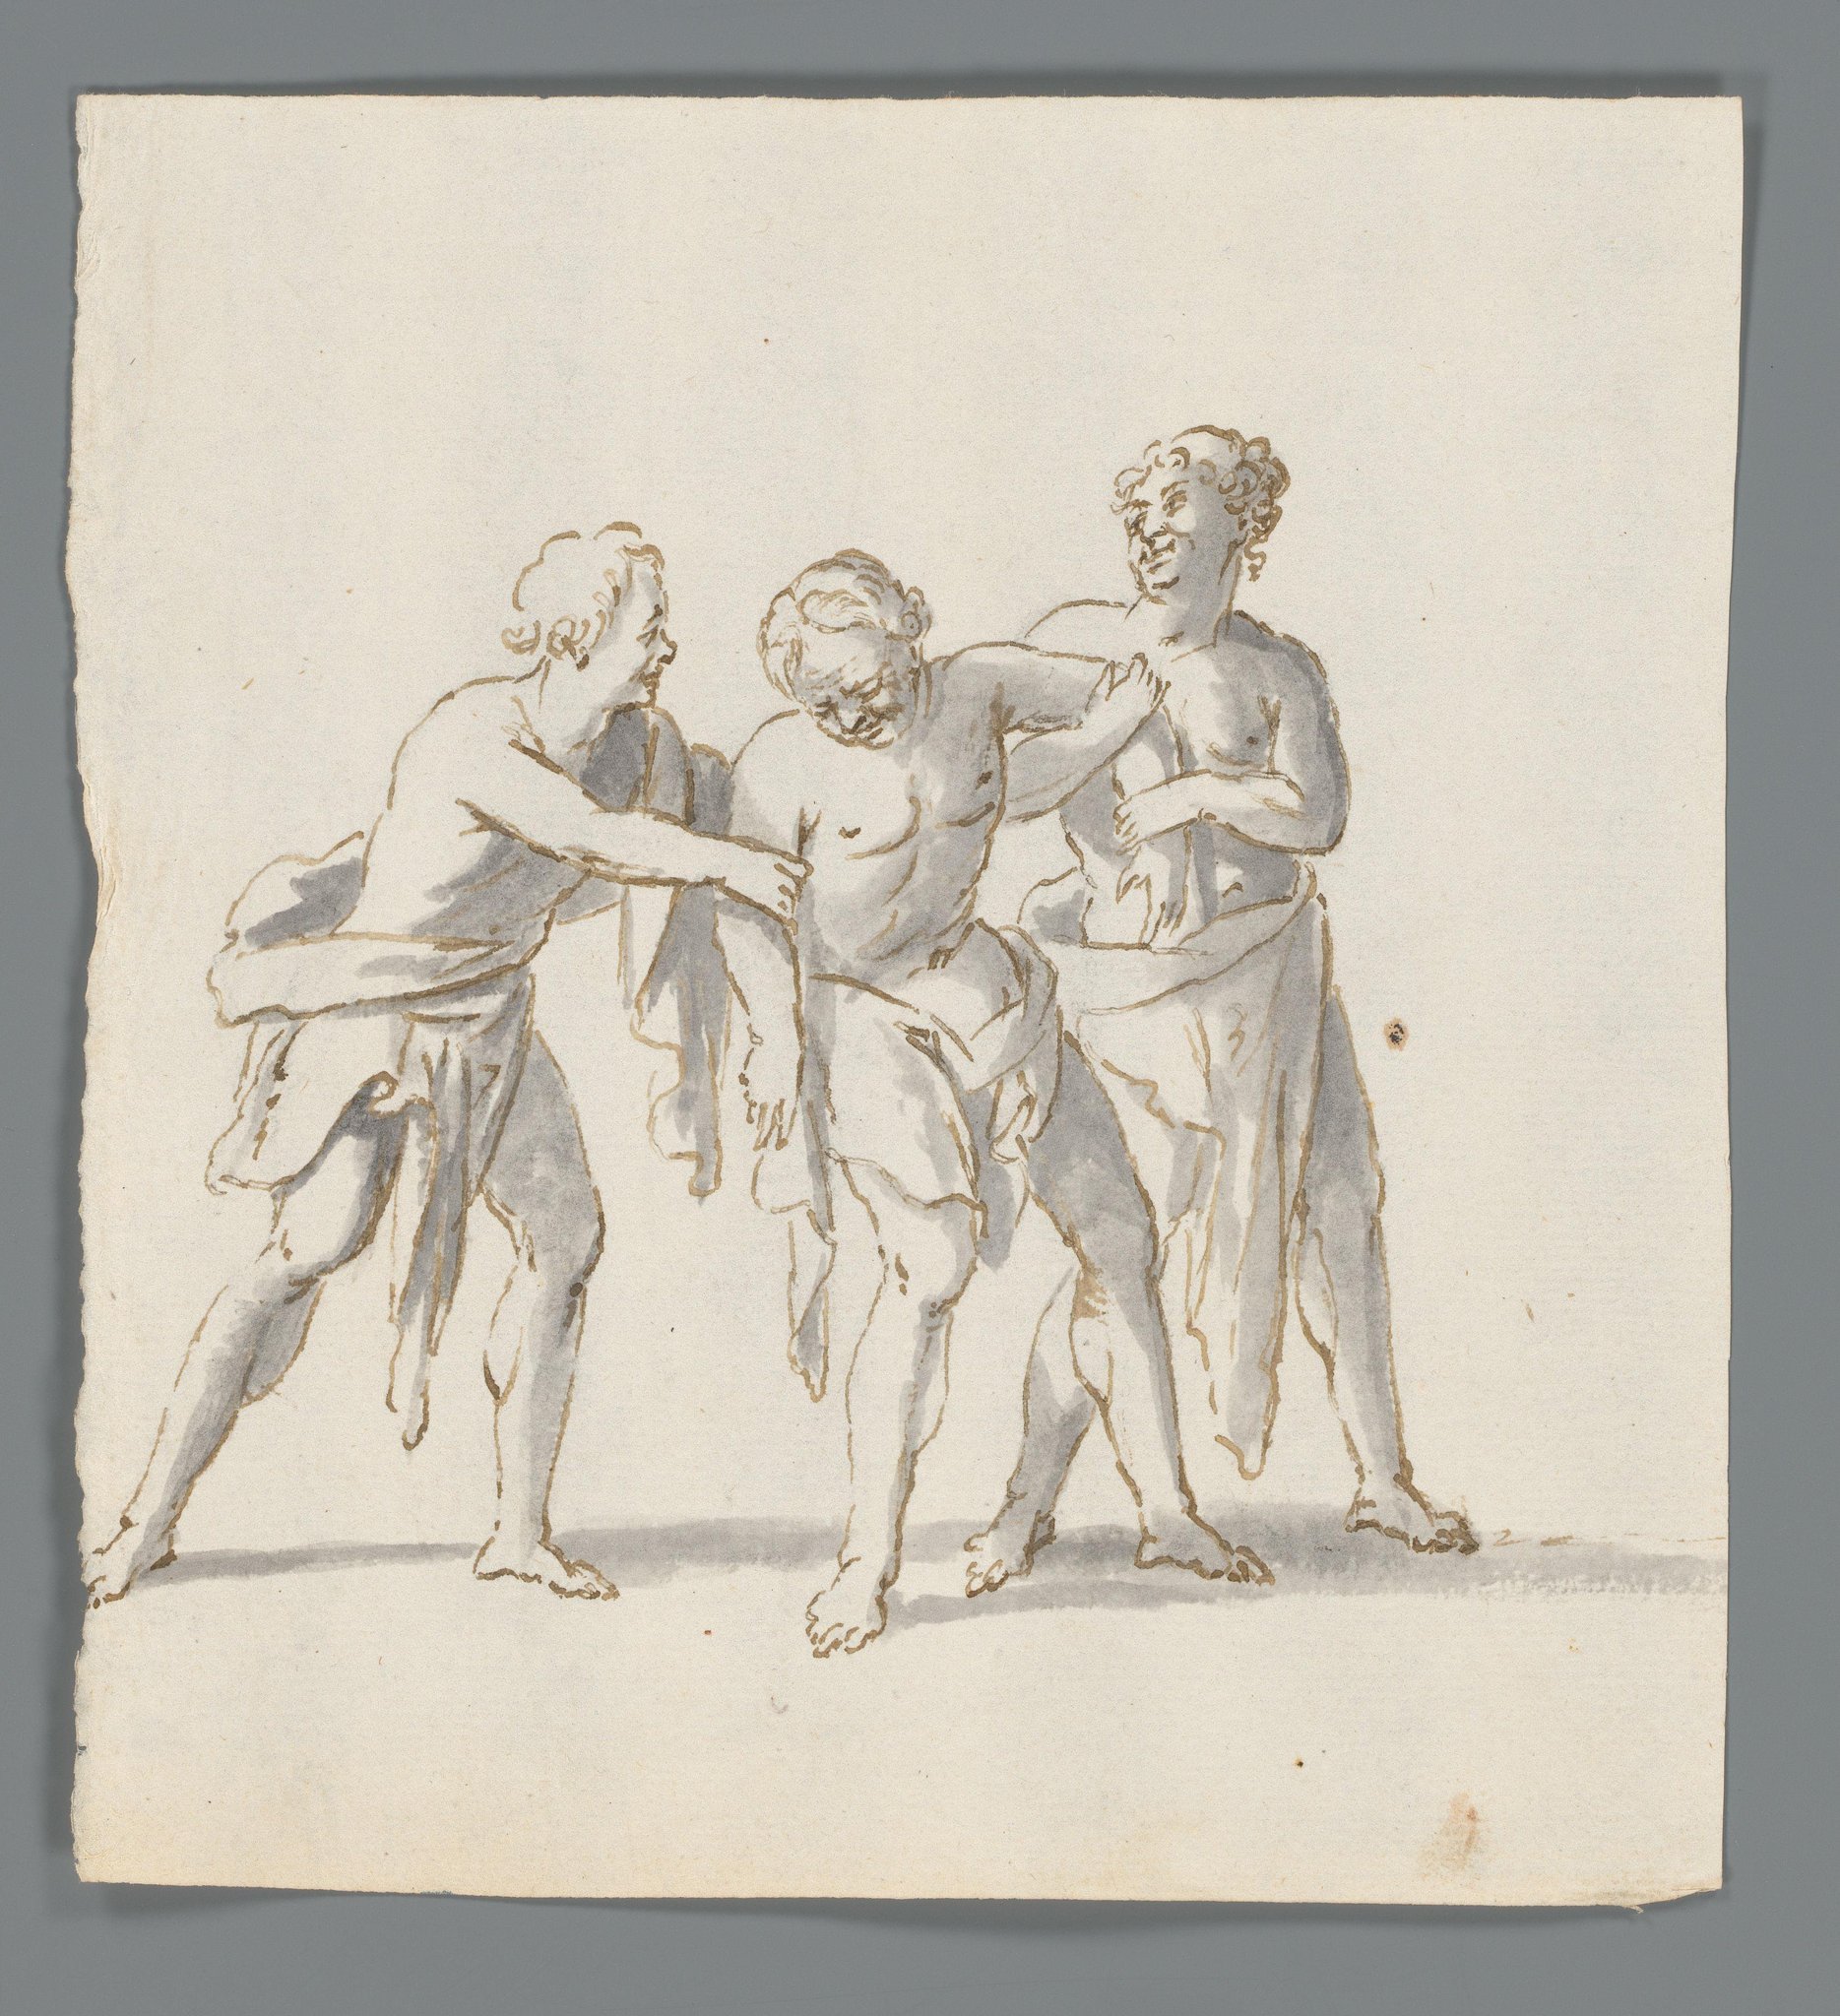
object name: drawing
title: Twee mannen houden een dronken man overeind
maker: matthijs balen (1684-1766)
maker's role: draughtsman, painter, print maker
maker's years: 1684-1766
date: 1694-1766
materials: paper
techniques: brush, pen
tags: drunkenness